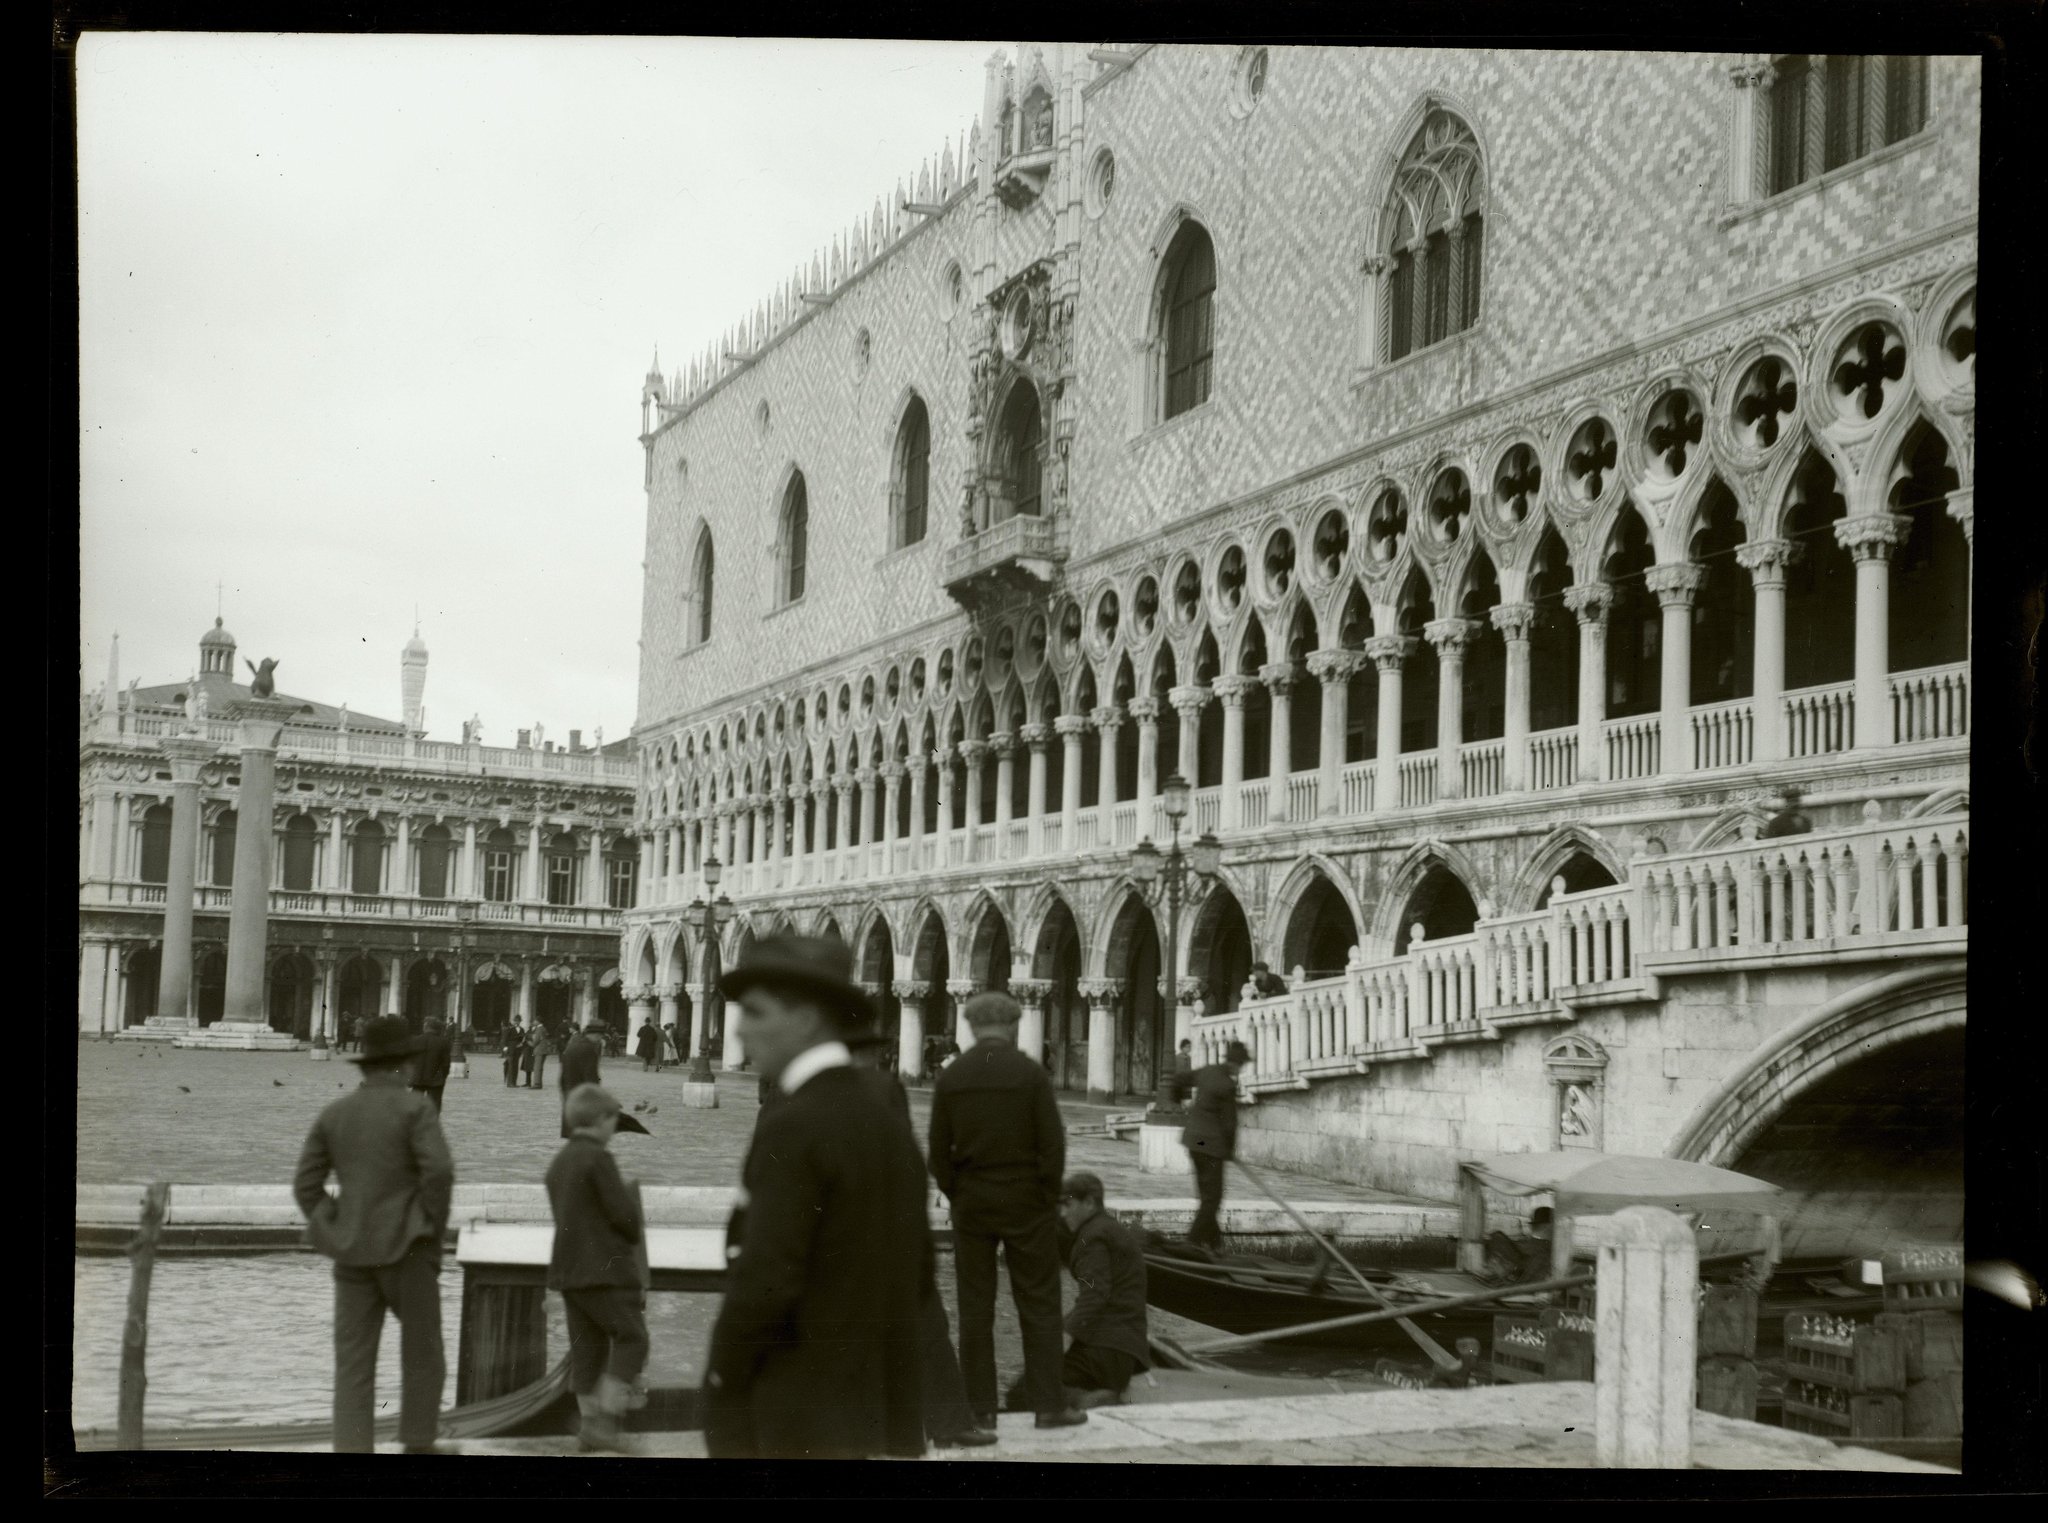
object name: photograph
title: Filmnegatief met opname van Venetië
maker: Anonymous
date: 1907-1935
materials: film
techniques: gelatin silver negative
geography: venice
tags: venice